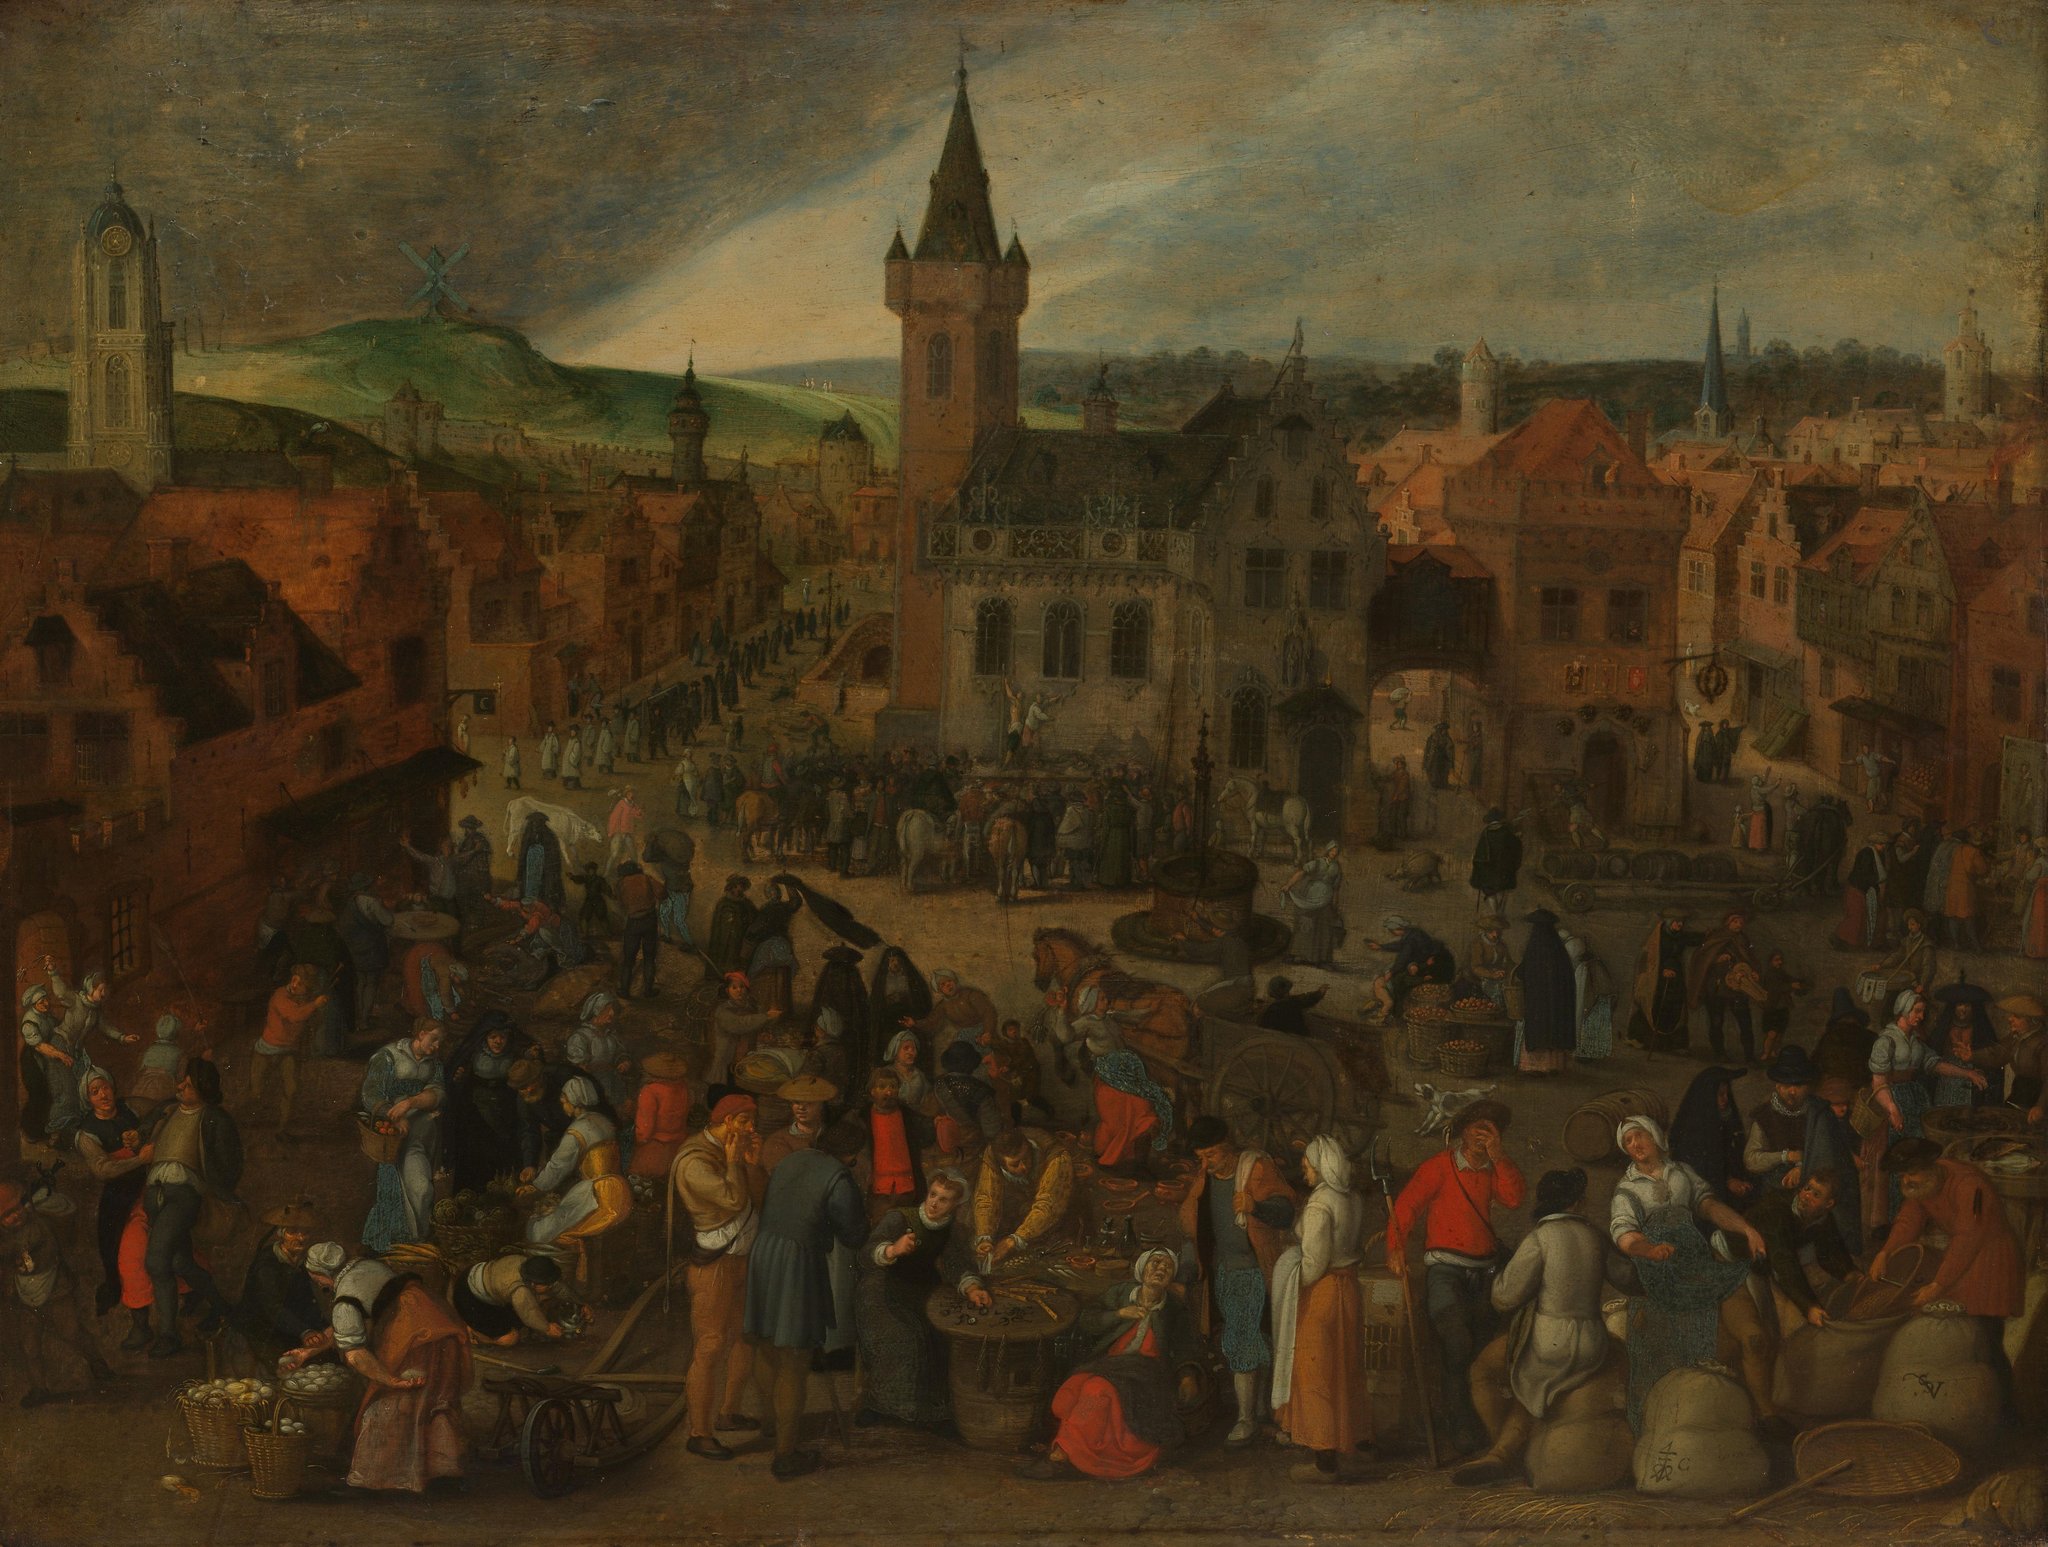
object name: painting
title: Market Day in a Flemish Town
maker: sebastiaen vrancx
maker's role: draughtsman, painter, print maker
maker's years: 1573-1647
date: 1600-1647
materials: oil, panel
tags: square, place, circus, etc., market, southern netherlands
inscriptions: signature: ‘SV’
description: Marktdag in een Vlaamse stad. Gezicht op een plein in een stad. Op de voorgrond bieden marktlui hun waar te koop: eieren, groente, fruit, brillen en fluiten, vis en graan. Links wordt er voor een herberg gedanst. Op een schavot voor het stadhuis wordt een man gegeseld.